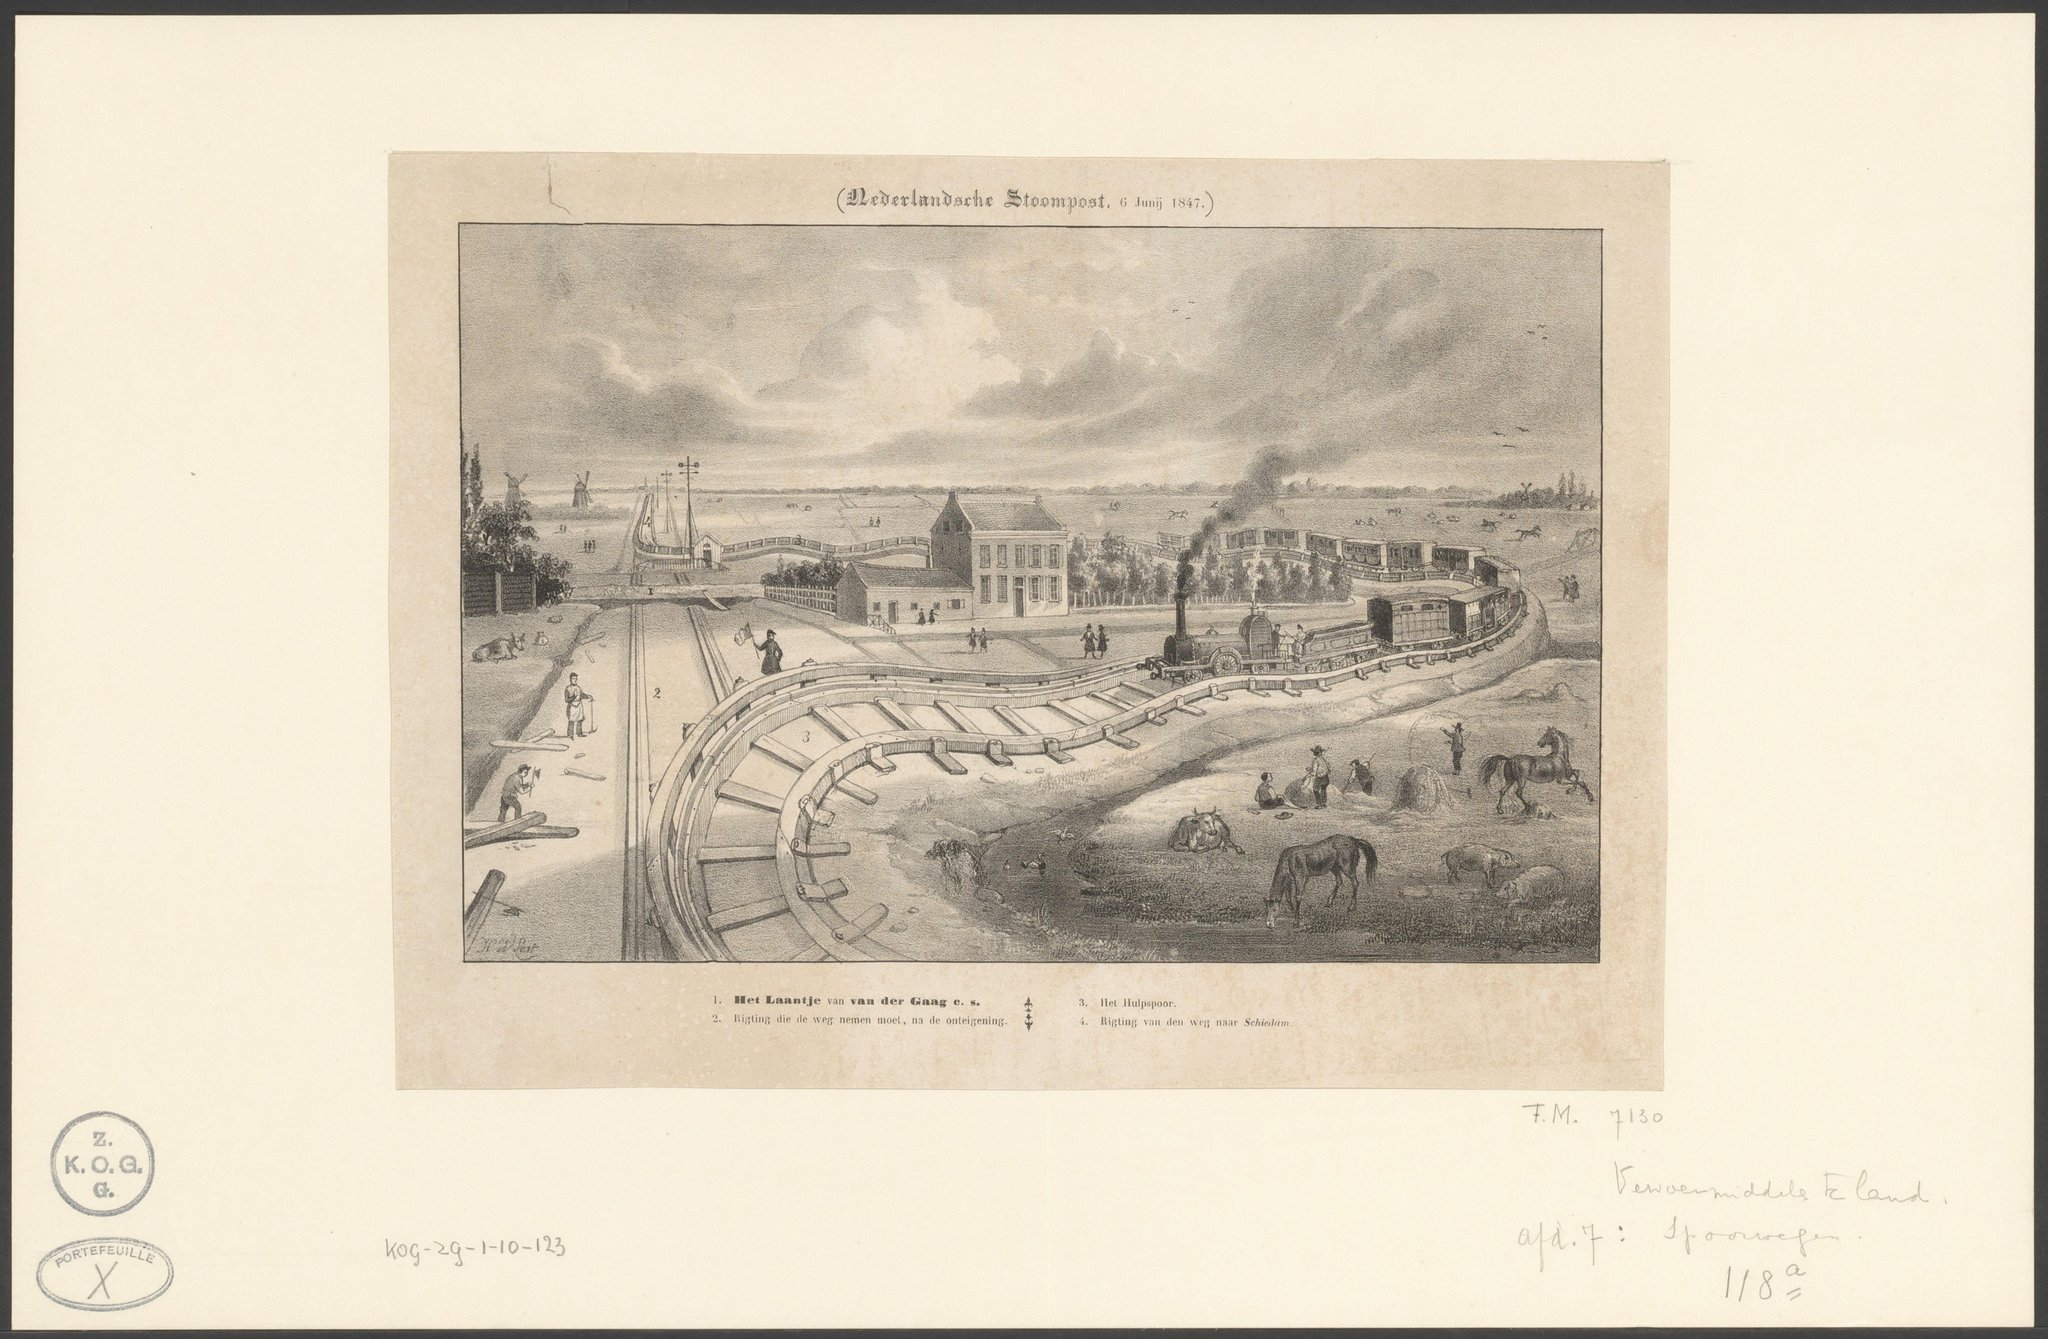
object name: print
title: Tijdelijke spoorweg vanwege het Laantje van Van der Gaag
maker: hendrik wilhelmus last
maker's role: print maker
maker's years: 1817-1873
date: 1847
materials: paper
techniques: lithograph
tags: locomotive, railway, tramway; rack railway, delft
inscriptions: collector's mark: Lugt 1641, stamp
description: Gezicht op het zogenaamde Laantje van Van der Gaag, een omleiding in de spoorlijn tussen Delft en Schiedam. Omdat Van der Gaag zijn land weigerde af te staan moest de spoorlijn in een grote bocht om het perceel worden aangelegd. Aan dit geval dankt de Onteigeningswet haar oorsprong. Het proces over deze zaak werd in juni 1847 beslist. De omleiding is in totaal vijf dagen gebruikt. Onderaan de legenda 1-4. Onderwerpsrubrieken binnen de Atlas Zeden en Gewoonten: Handel, nijverheid en verkeer, Vervoermiddelen te land en te water, vervoermiddelen te land, Spoorwegen.